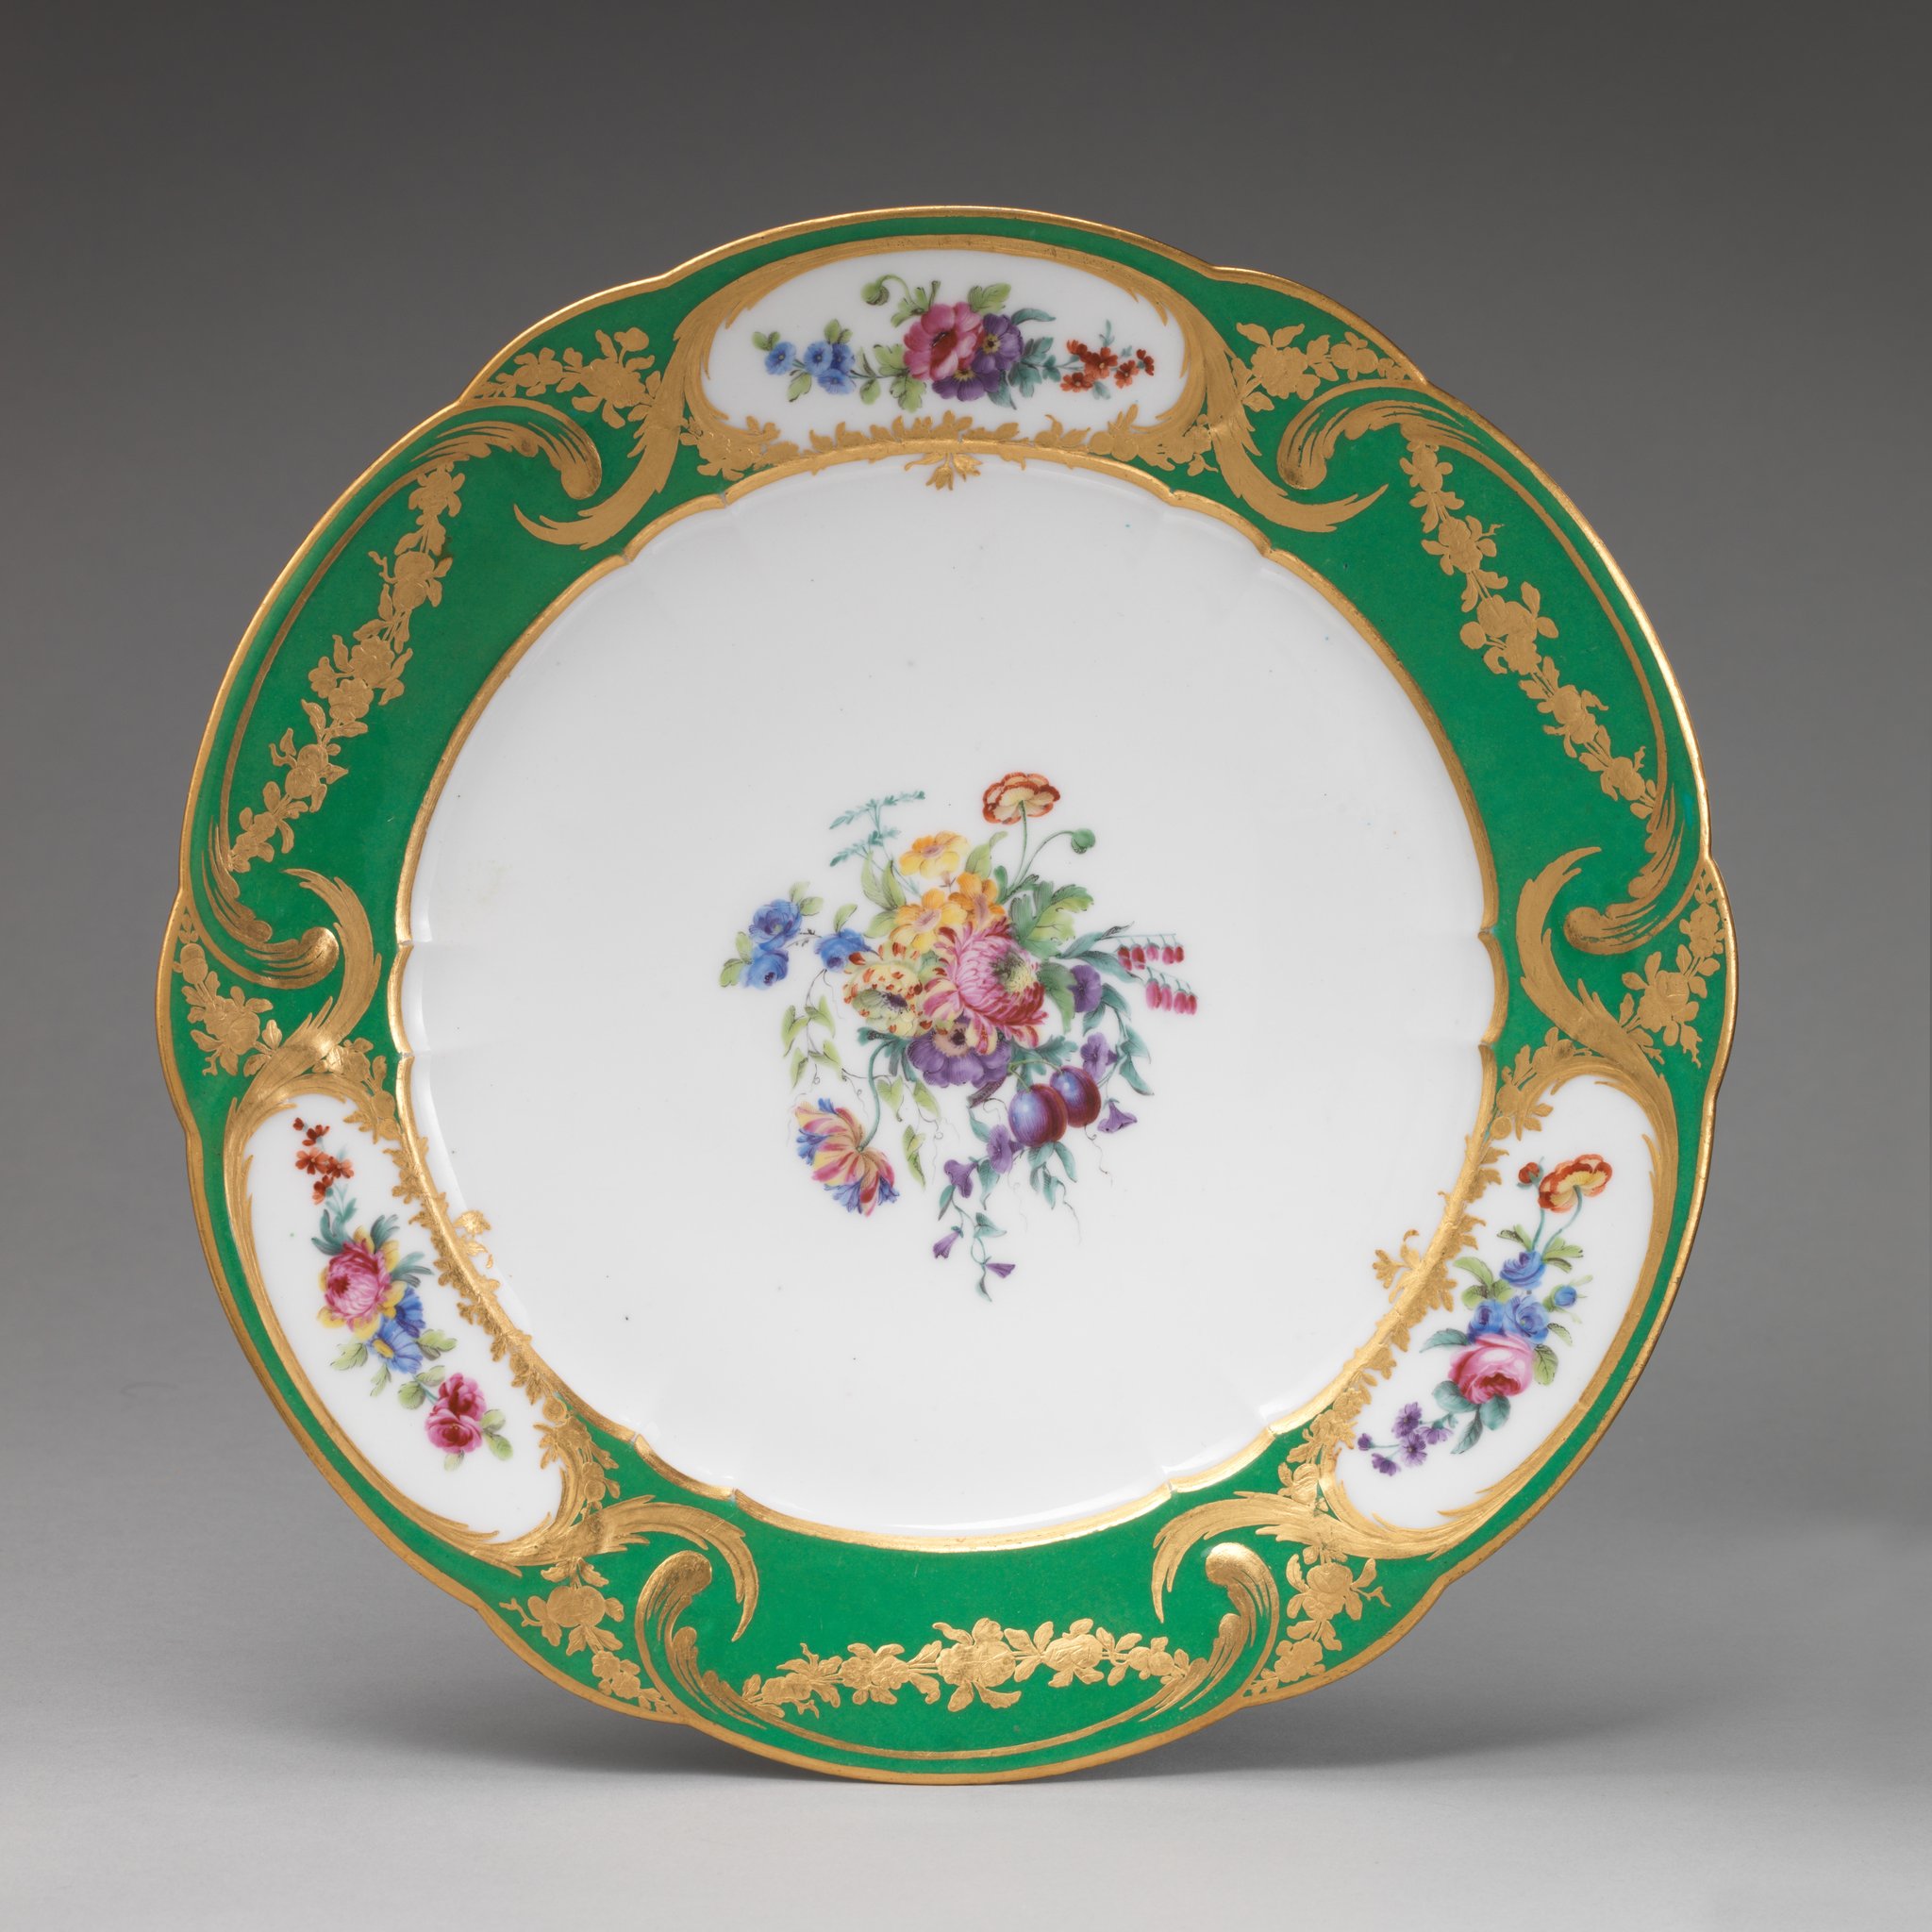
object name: plate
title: Plate (assiette à palmes) (1 of 102) (part of a service)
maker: sèvres manufactory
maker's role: manufactory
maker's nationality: french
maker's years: 1740-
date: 1780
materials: soft paste porcelain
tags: flowers